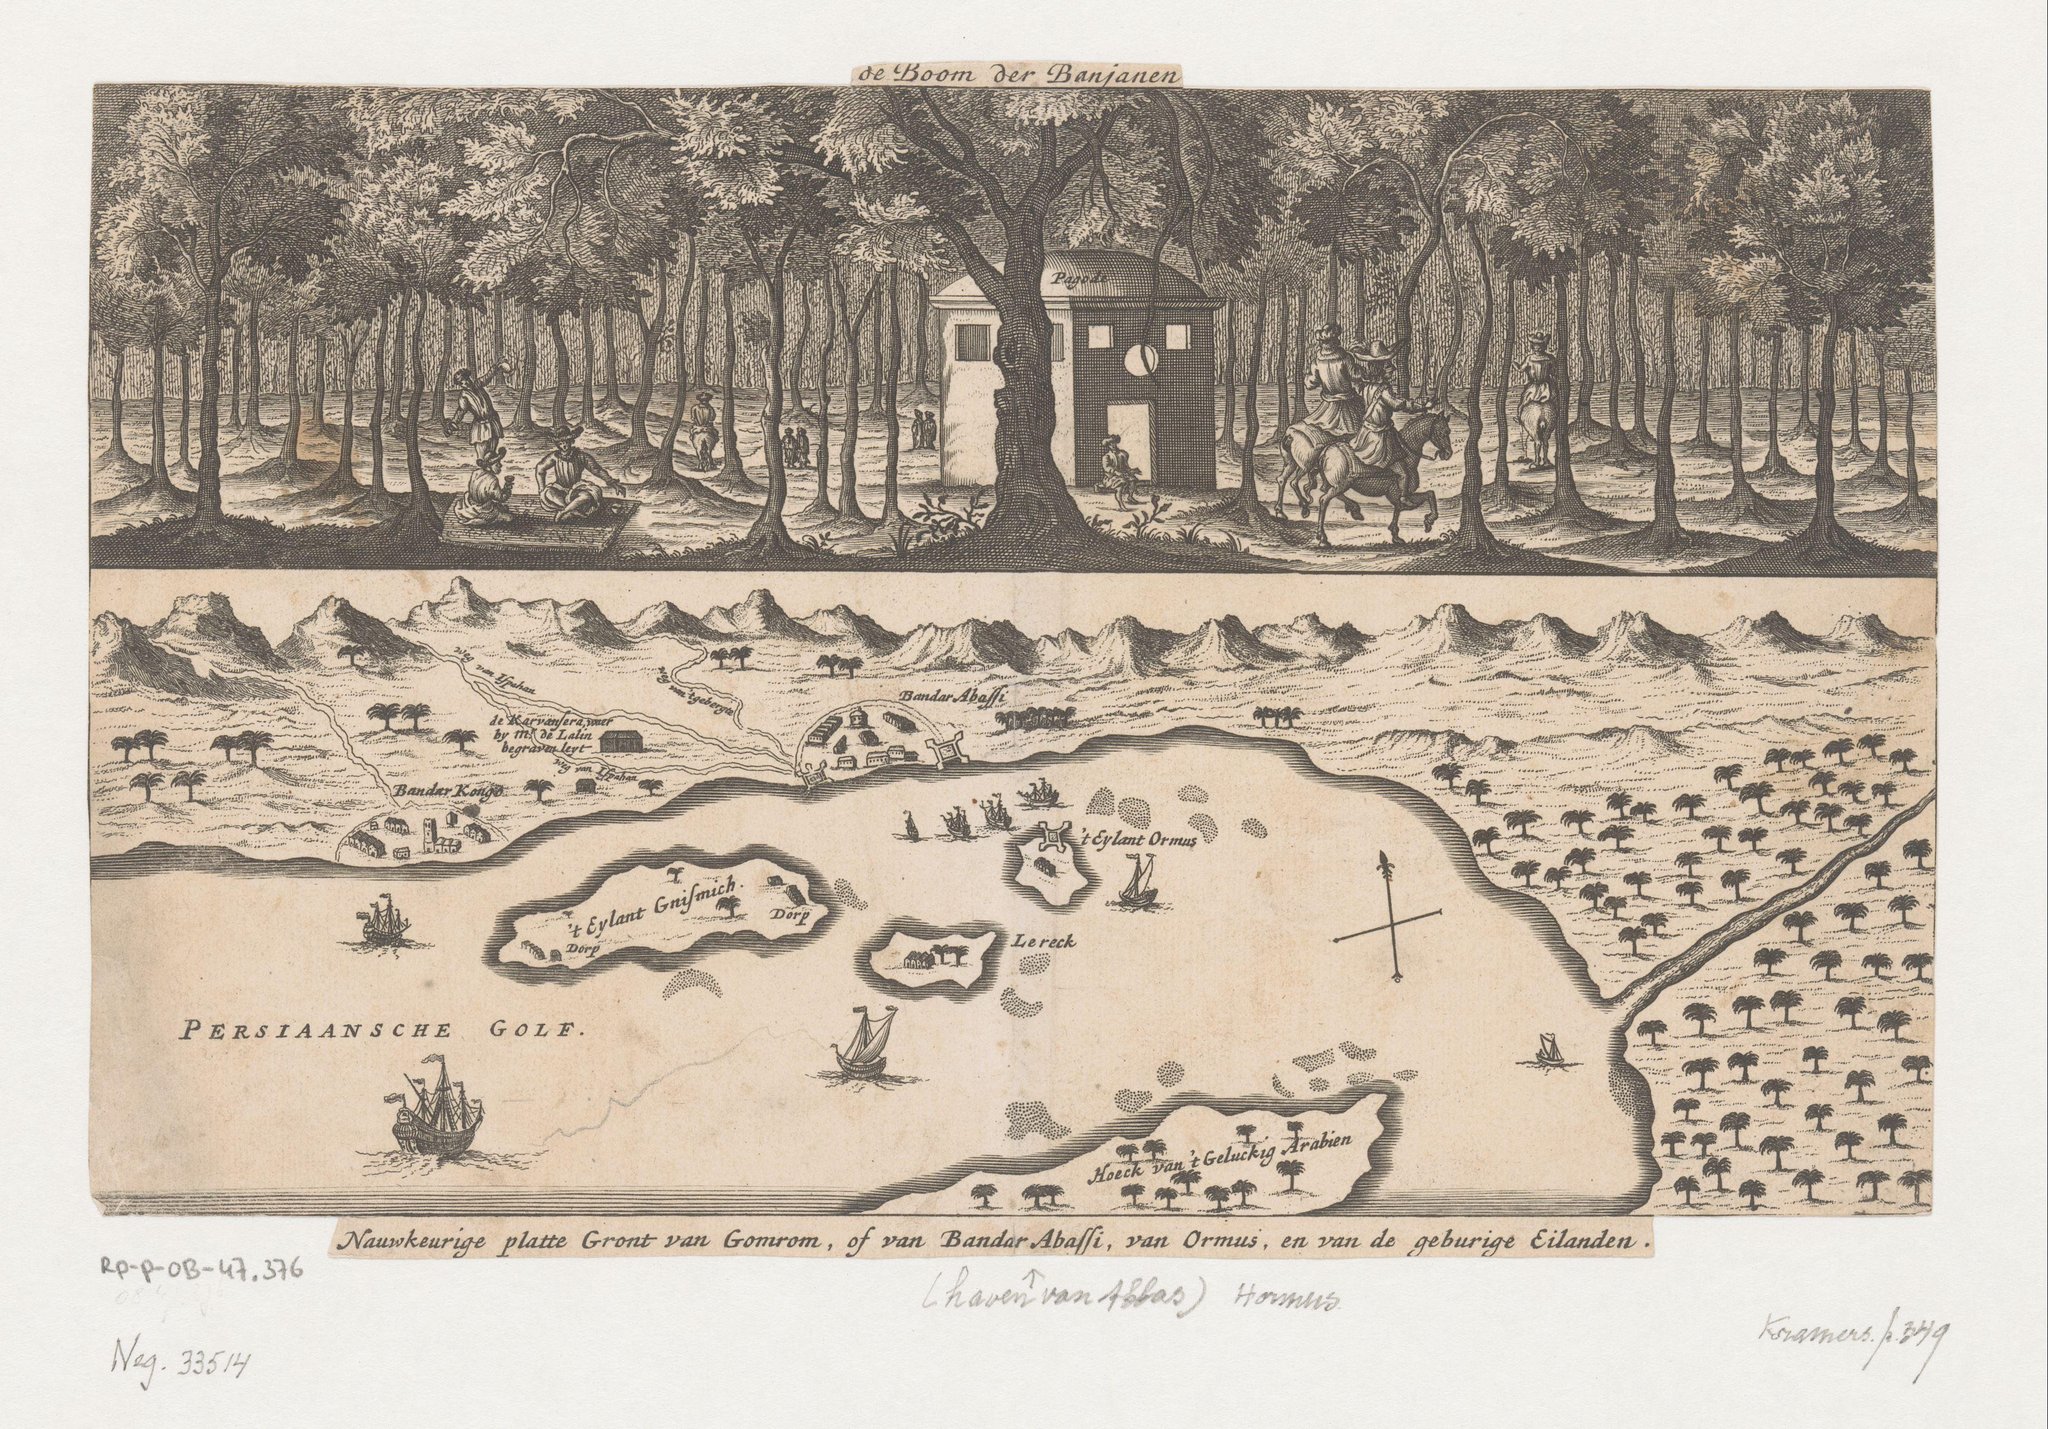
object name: print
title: Boom der Banjanen en plattegrond van Gomrom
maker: Anonymous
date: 1682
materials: paper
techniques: etching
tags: maps, atlases, forest, wood, persia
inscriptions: collector's mark: Lugt 2228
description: Onder een vogelvluchtkaart van een deel van de Perzische Golf. Boven een aanzicht van een bos met in het midden 'De Boom der Banjanen' met pagode en figuren te paard.